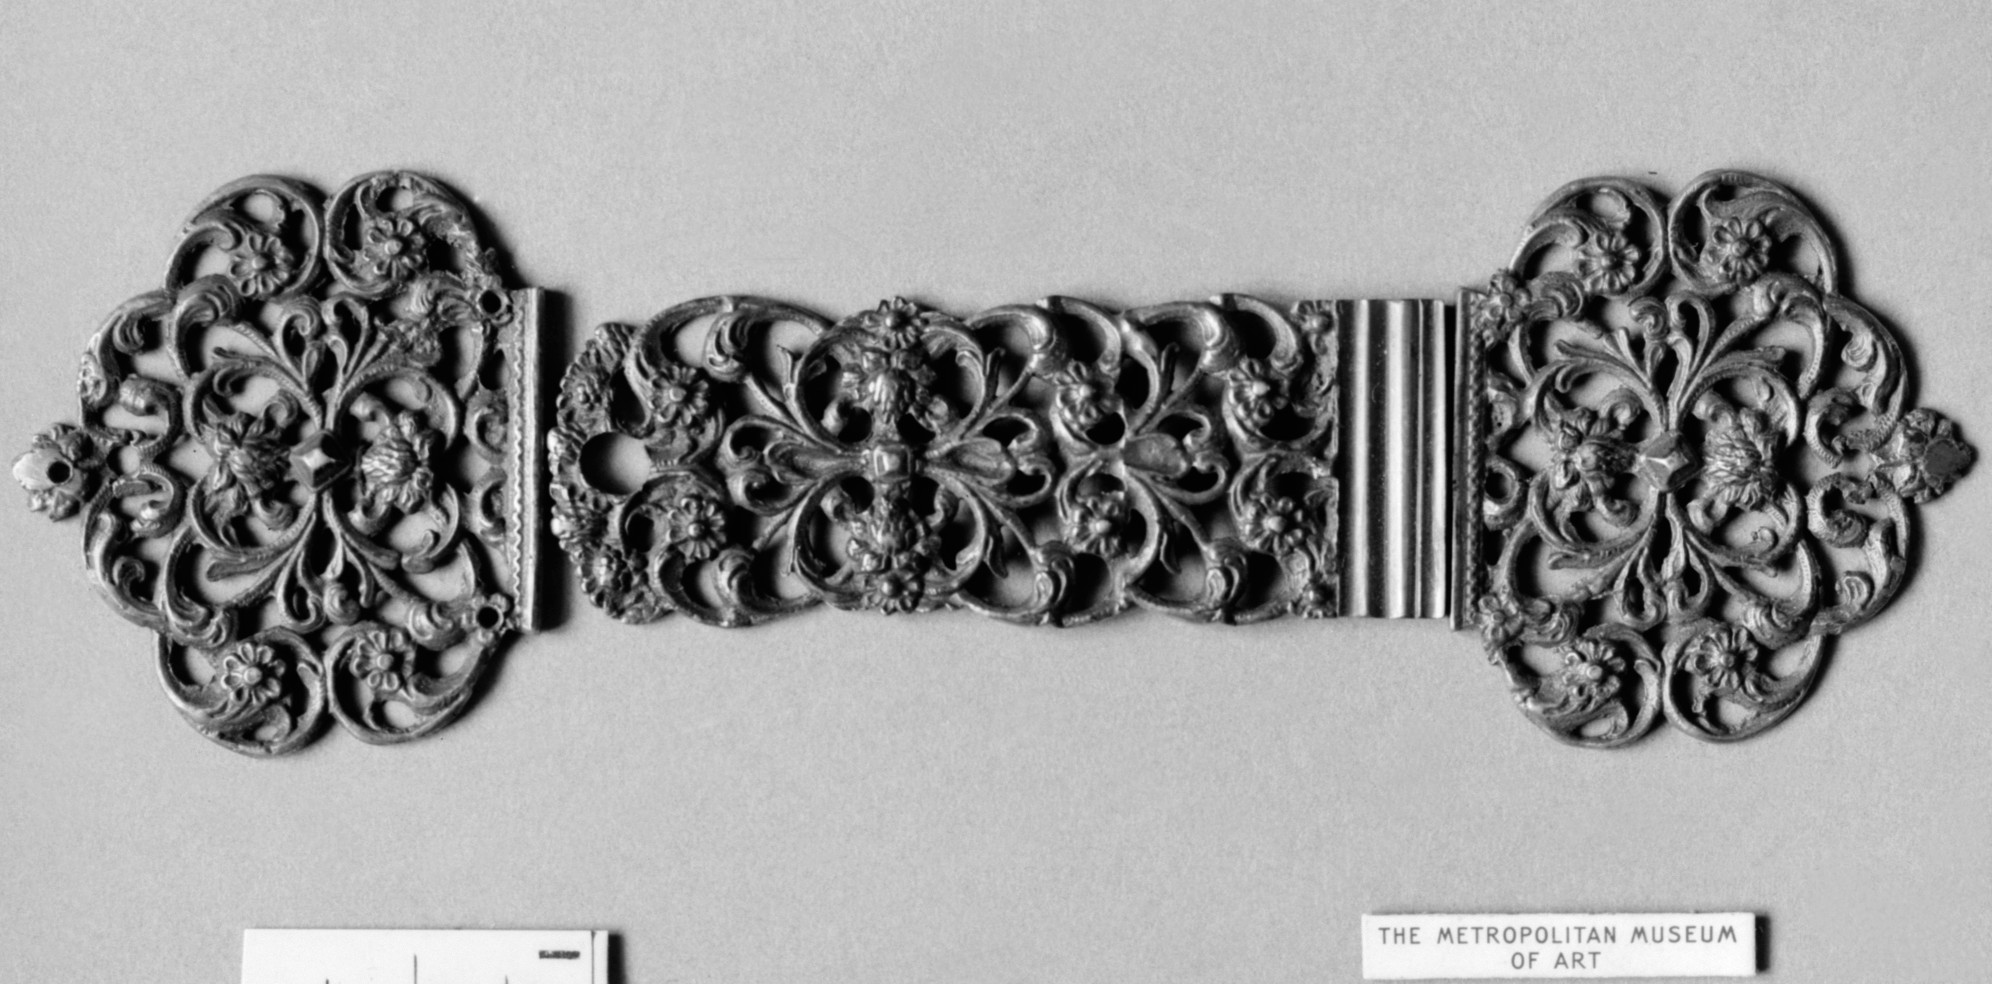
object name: book clasp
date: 1601-1700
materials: silver